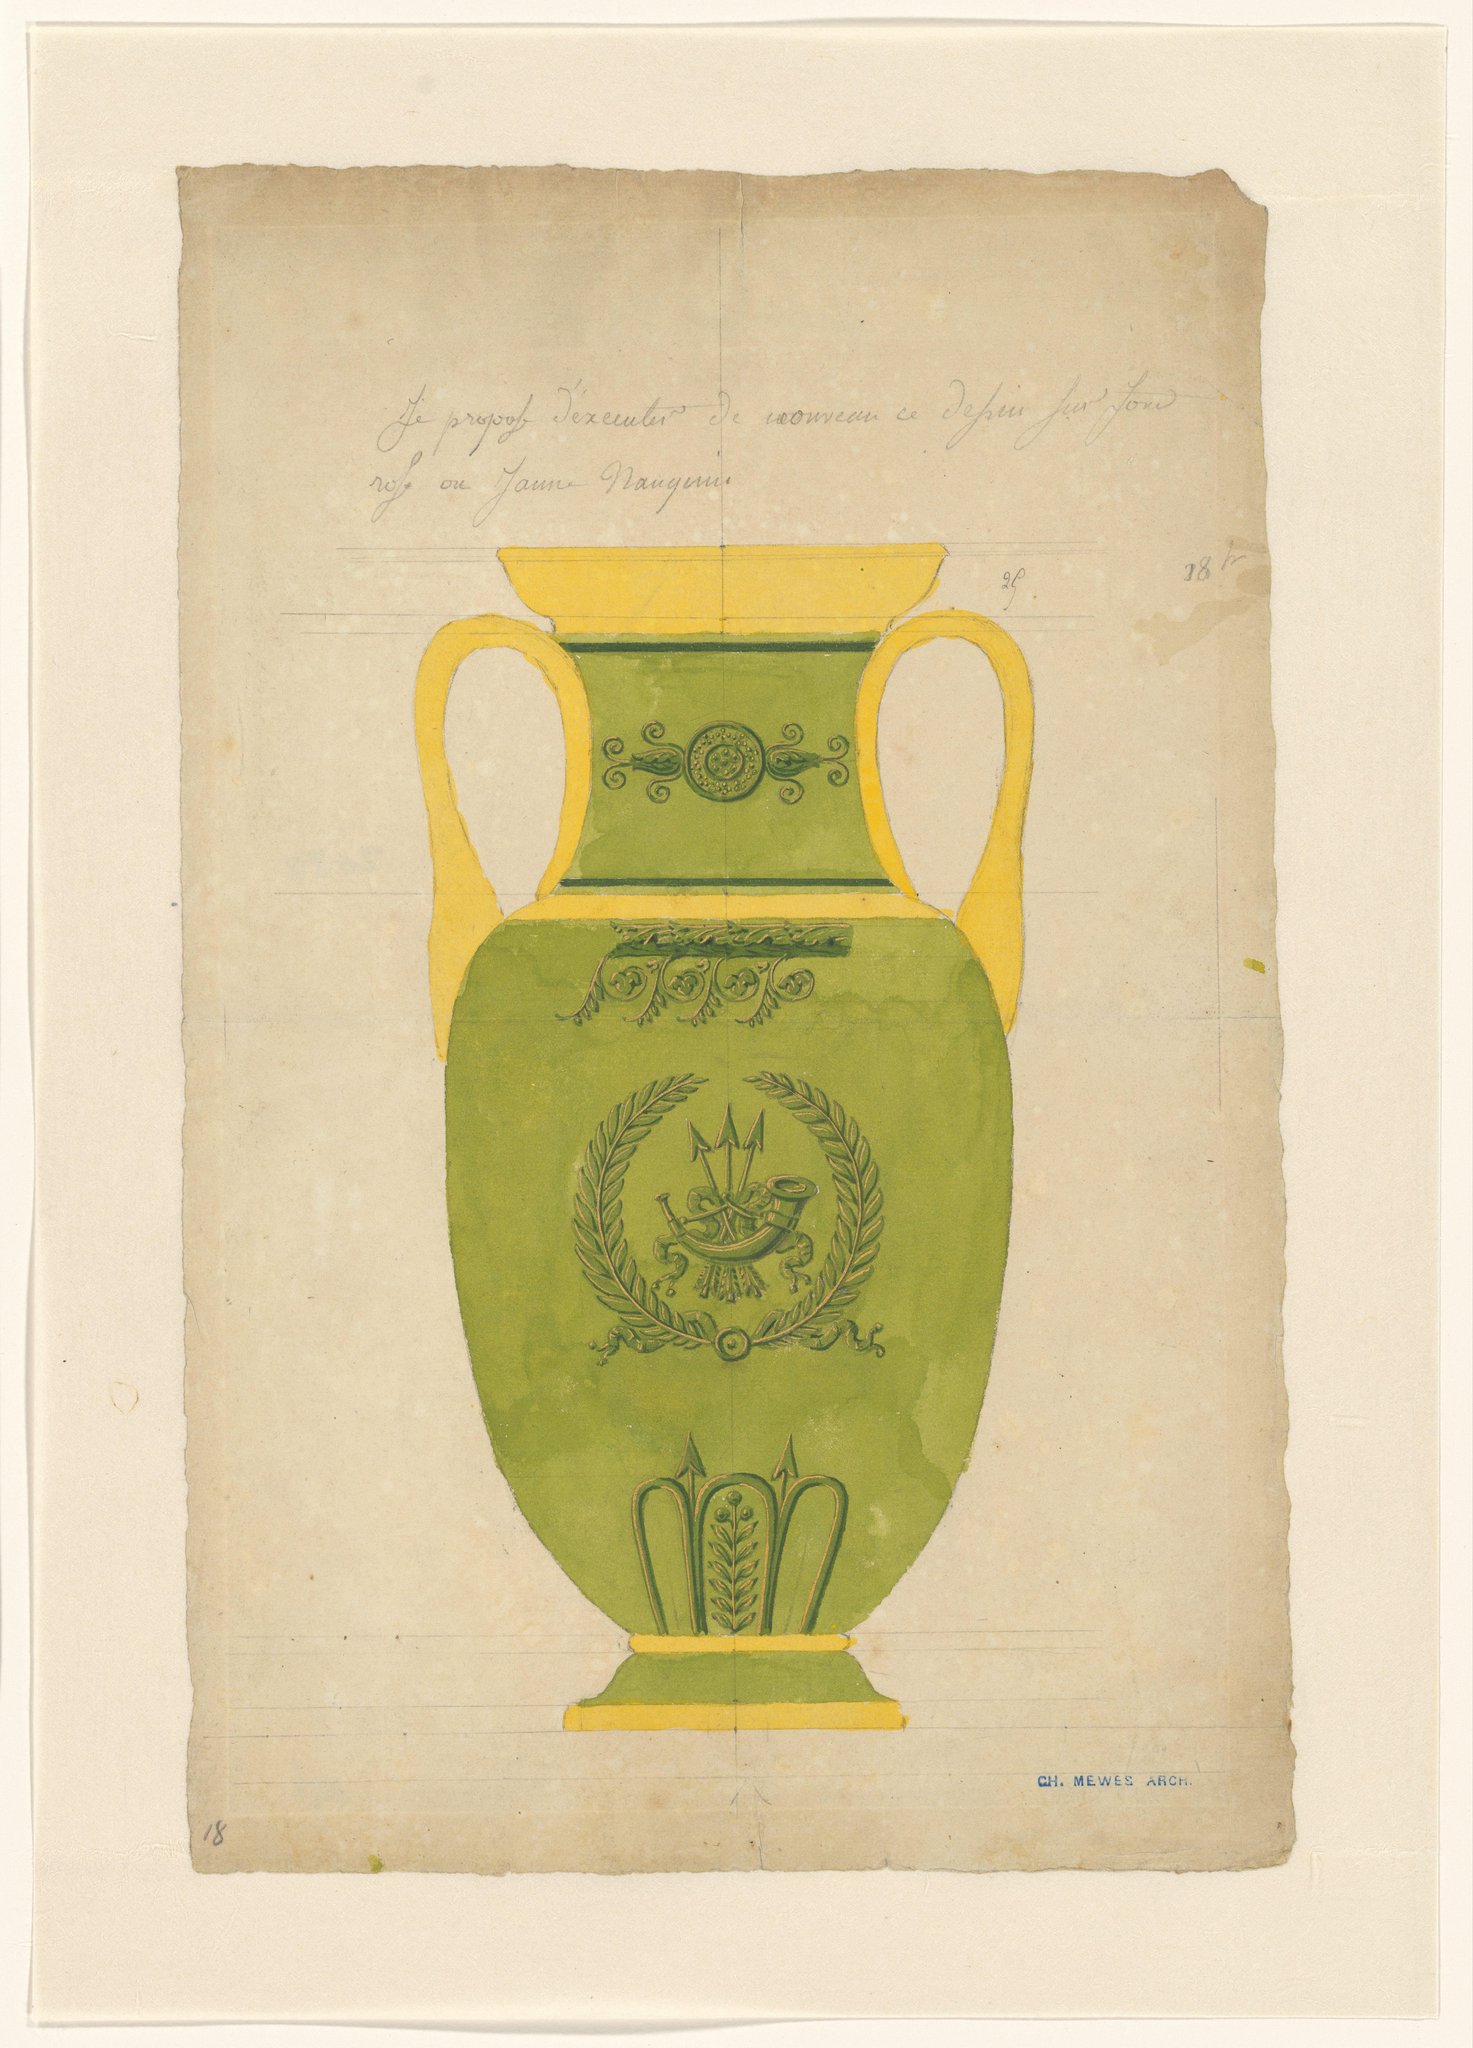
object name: design drawing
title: Ontwerp voor een vaas van Sèvres porselein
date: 1805-1815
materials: chalk, gold, graphite, paper, watercolor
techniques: aquarelle, drawing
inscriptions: watermark: ‘Dul[…]’, collector's mark: Lugt 4173, inscription: ‘Je propose d’executer de nouveau ce dessein sur fond rose ou Jaune Nanquin / 2G / 18 fr / 18’